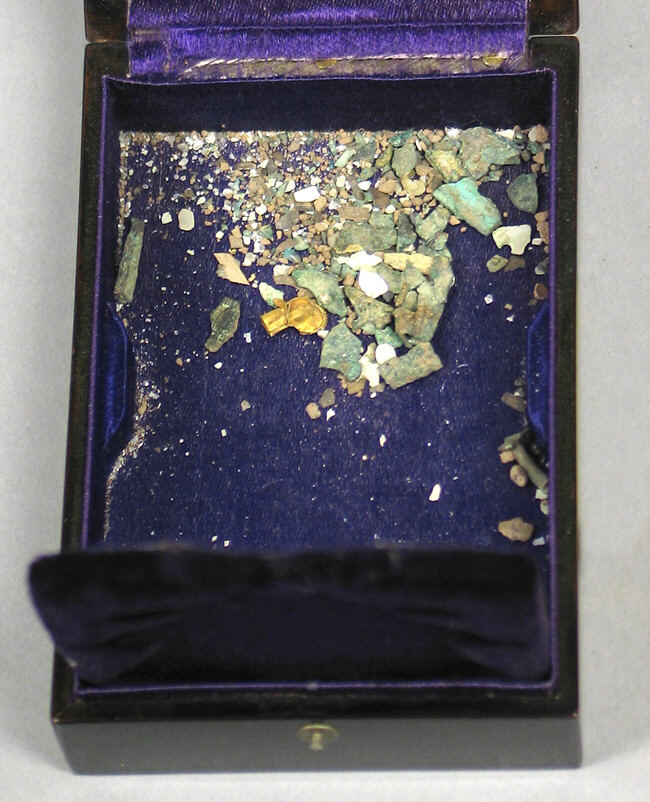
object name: box of remnant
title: Box of Remnants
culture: chinese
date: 618-907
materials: bronze, gold, mother of pearl, pearl